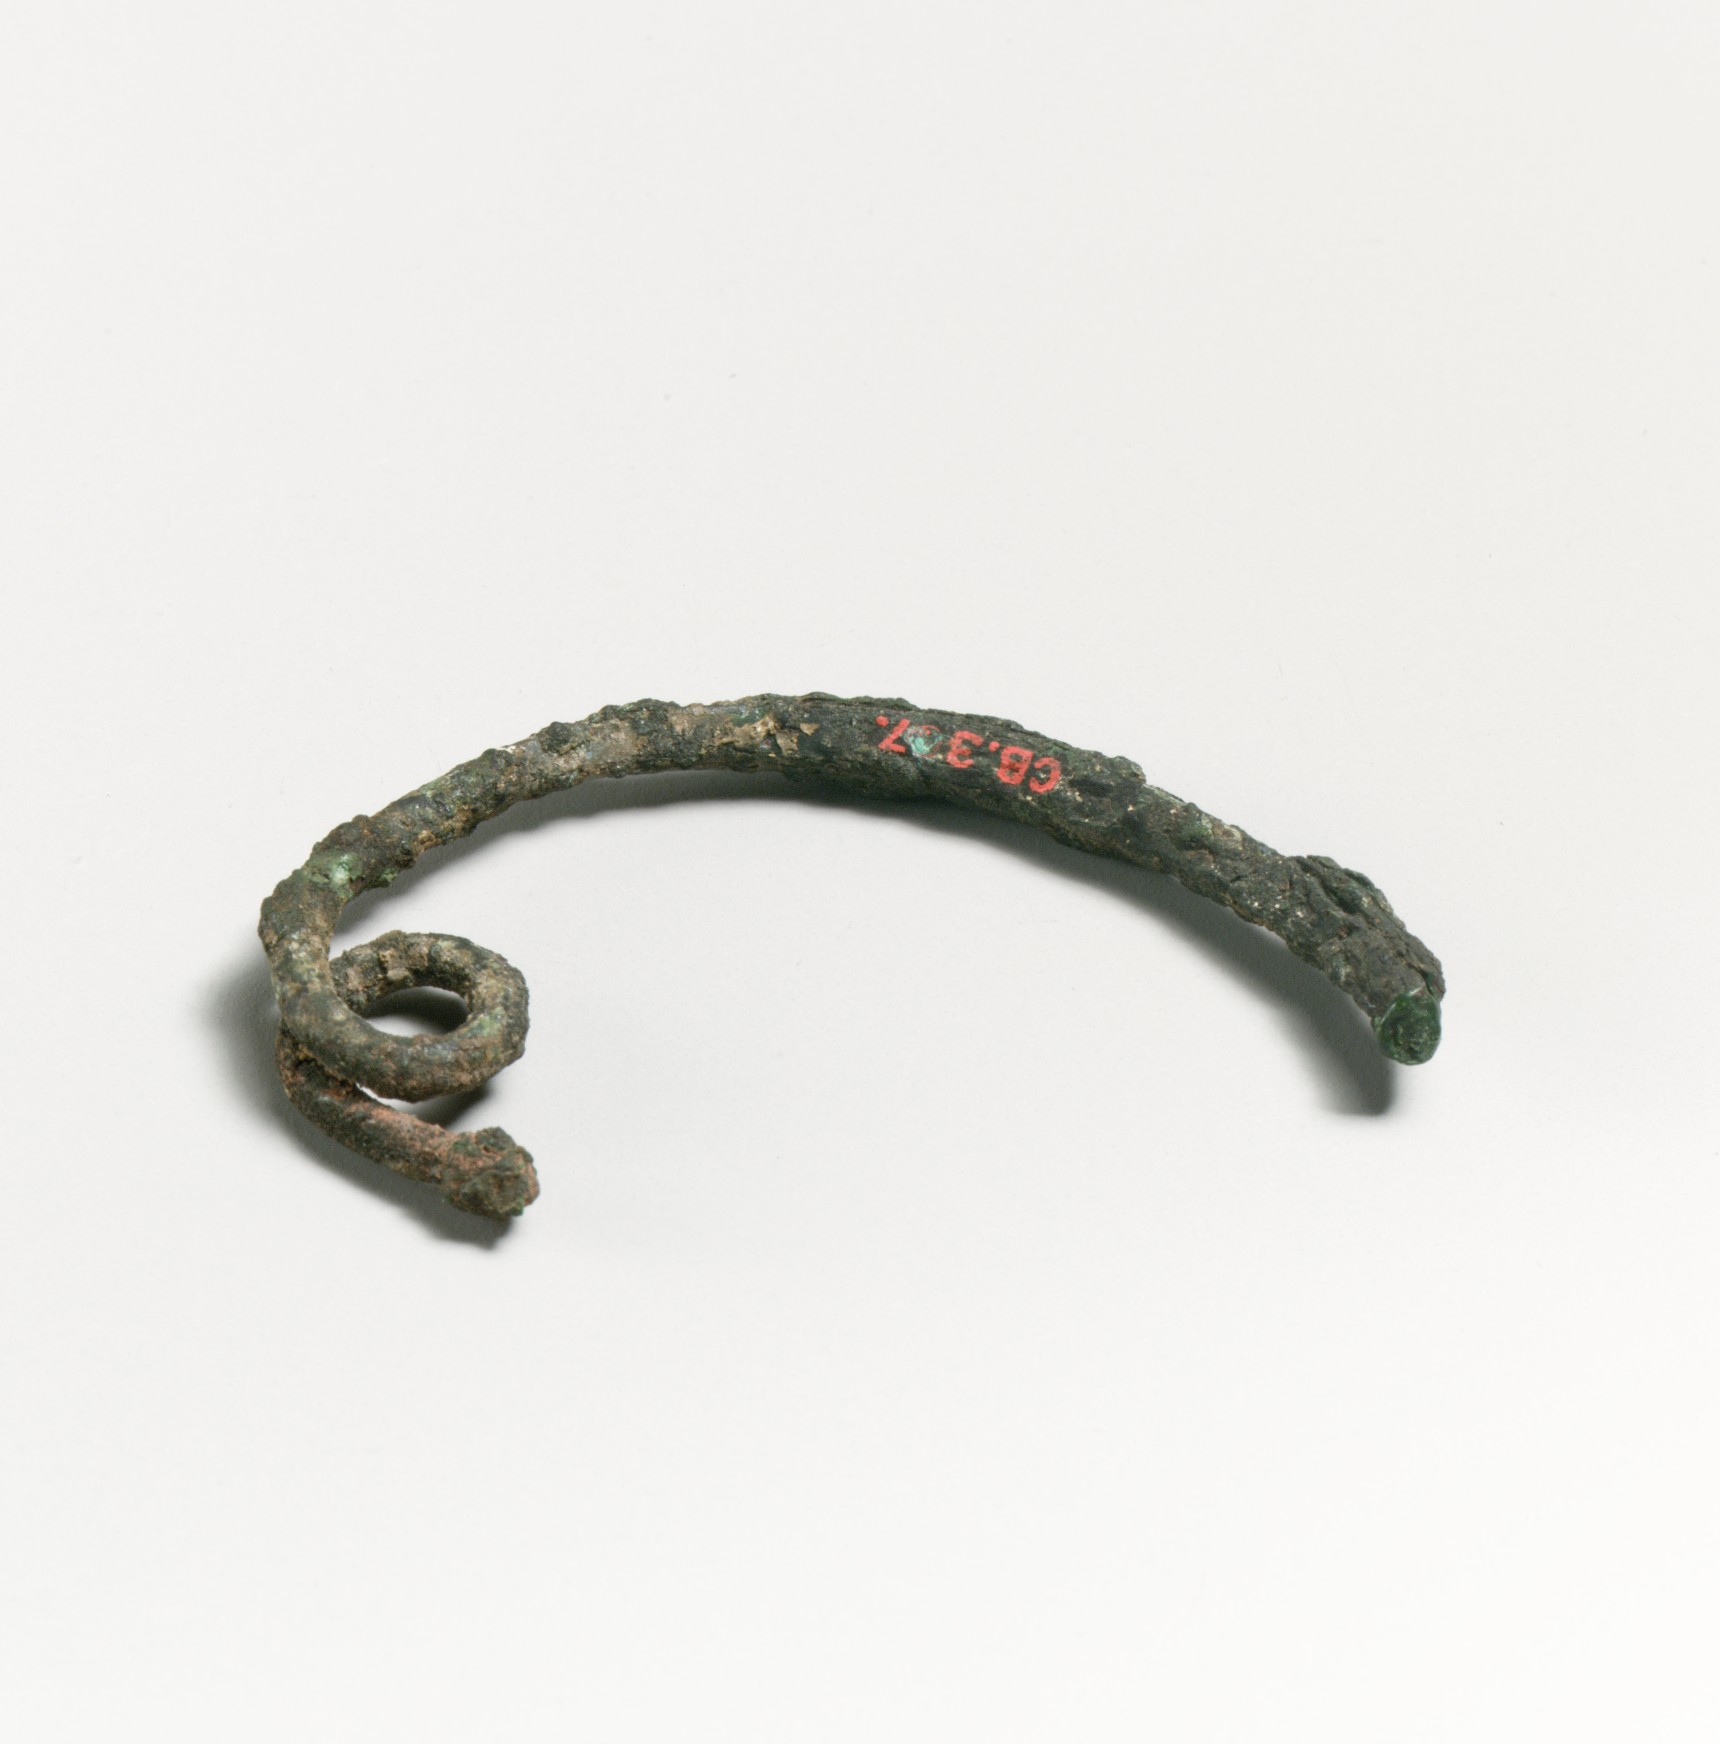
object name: fibula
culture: cypriot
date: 3900 BCE-100 CE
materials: bronze